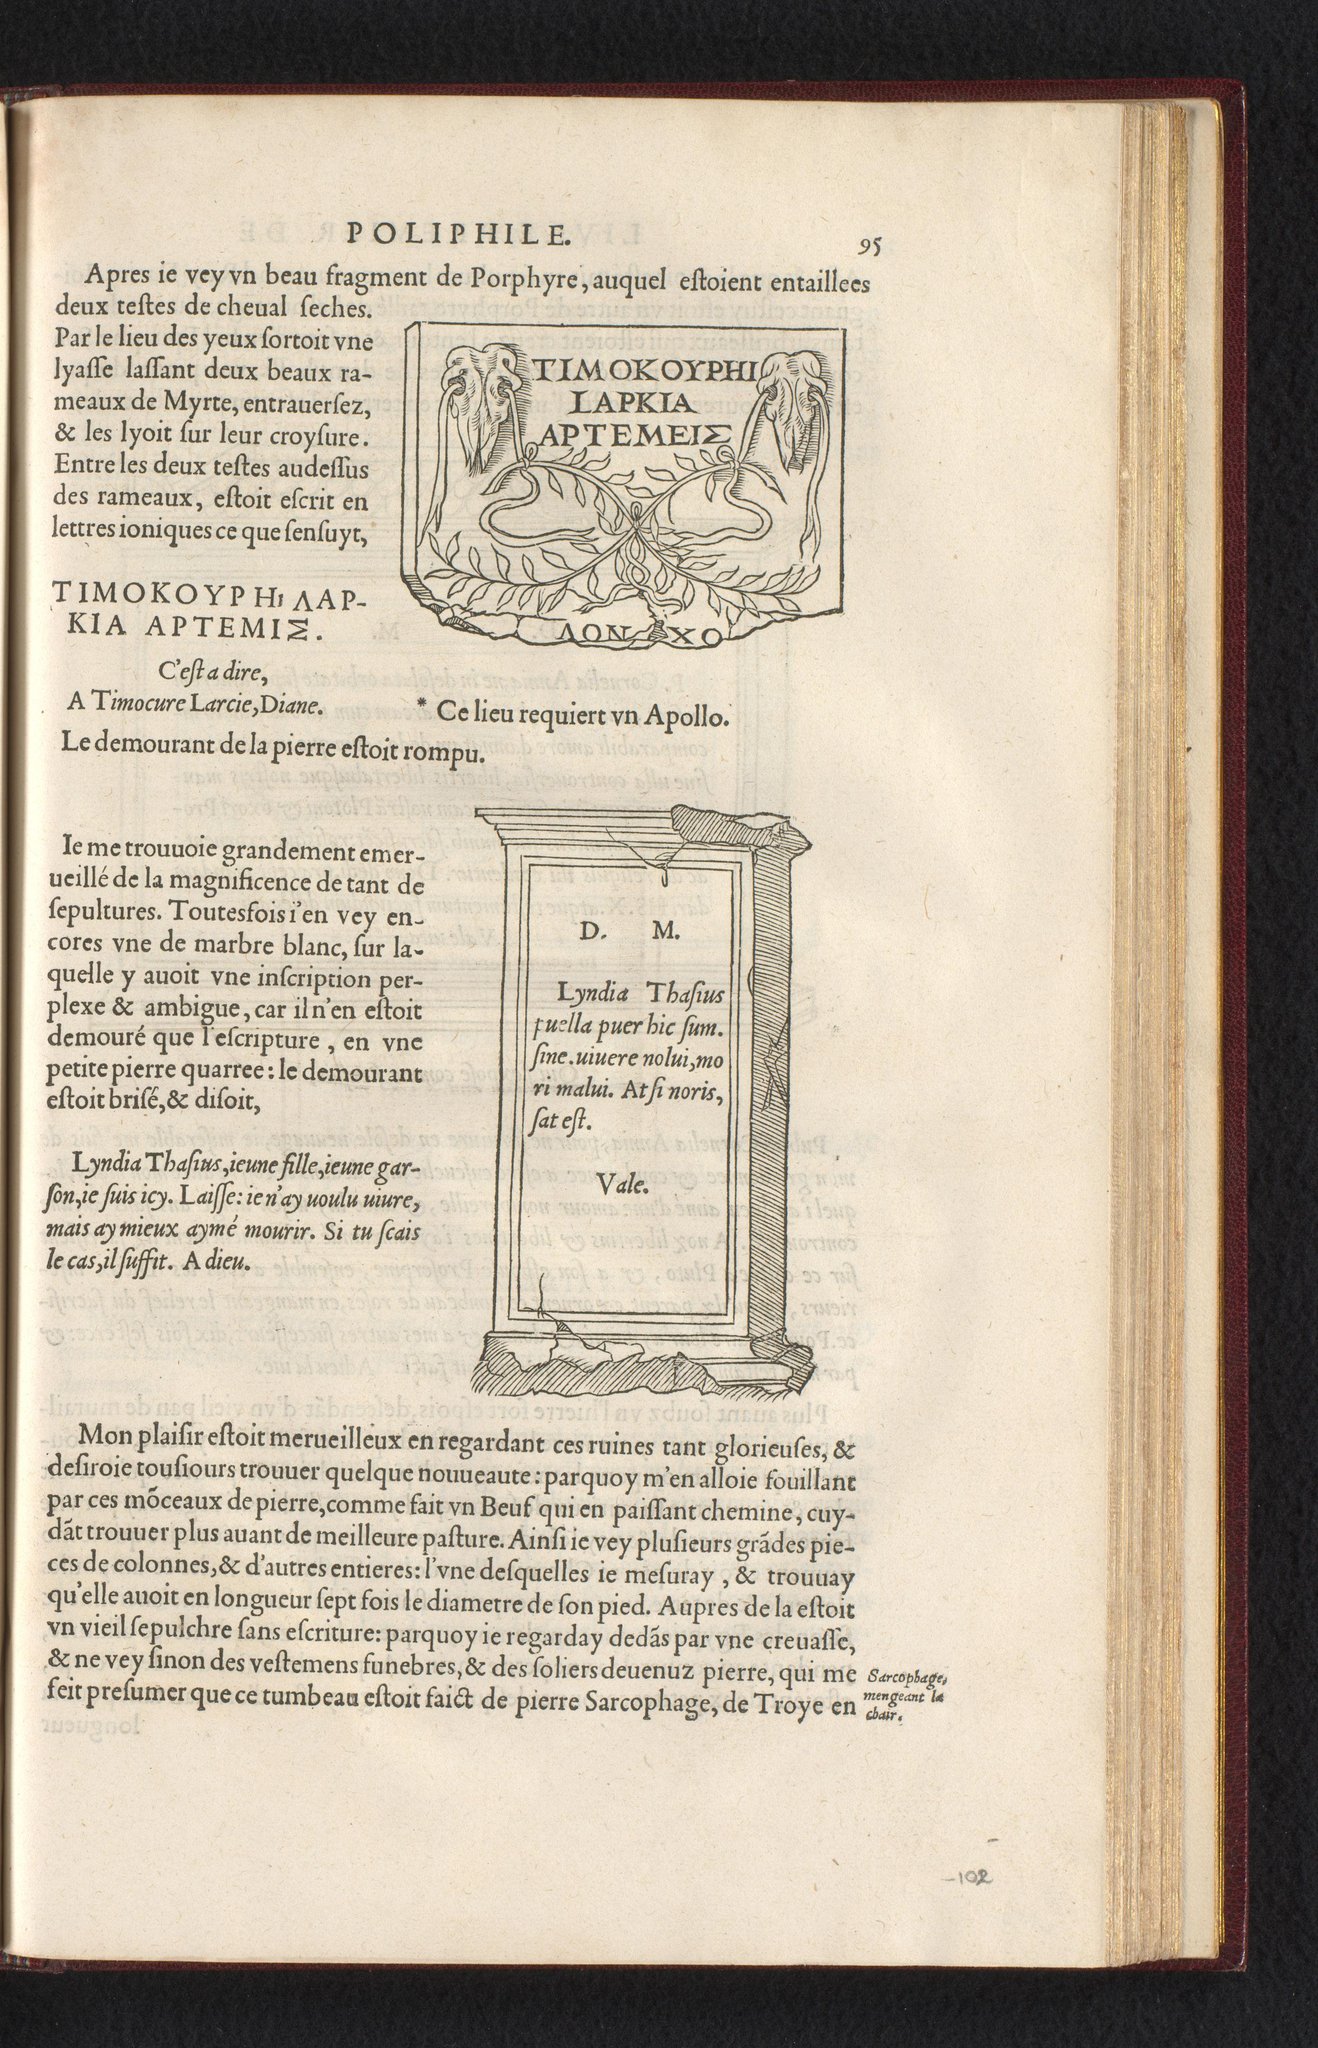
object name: print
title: Sokkel en fragment met opschrift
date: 1546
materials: paper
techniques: letterpress printing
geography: paris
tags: inscription, (scenes from) specific works of literature: colonna, hypnerotomachia poliphili, pedestal of a piece of sculpture (perhaps in the form of a herm), death's head, skull (symbol of death)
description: Prent uit: Colonna, Francesco. Hypnerotomachie ou discours du songe de Poliphile, deduisant comme amour le combat a l'occasion de Polia. Parijs: Jacques Kerver, 1546, recto fol. 95.